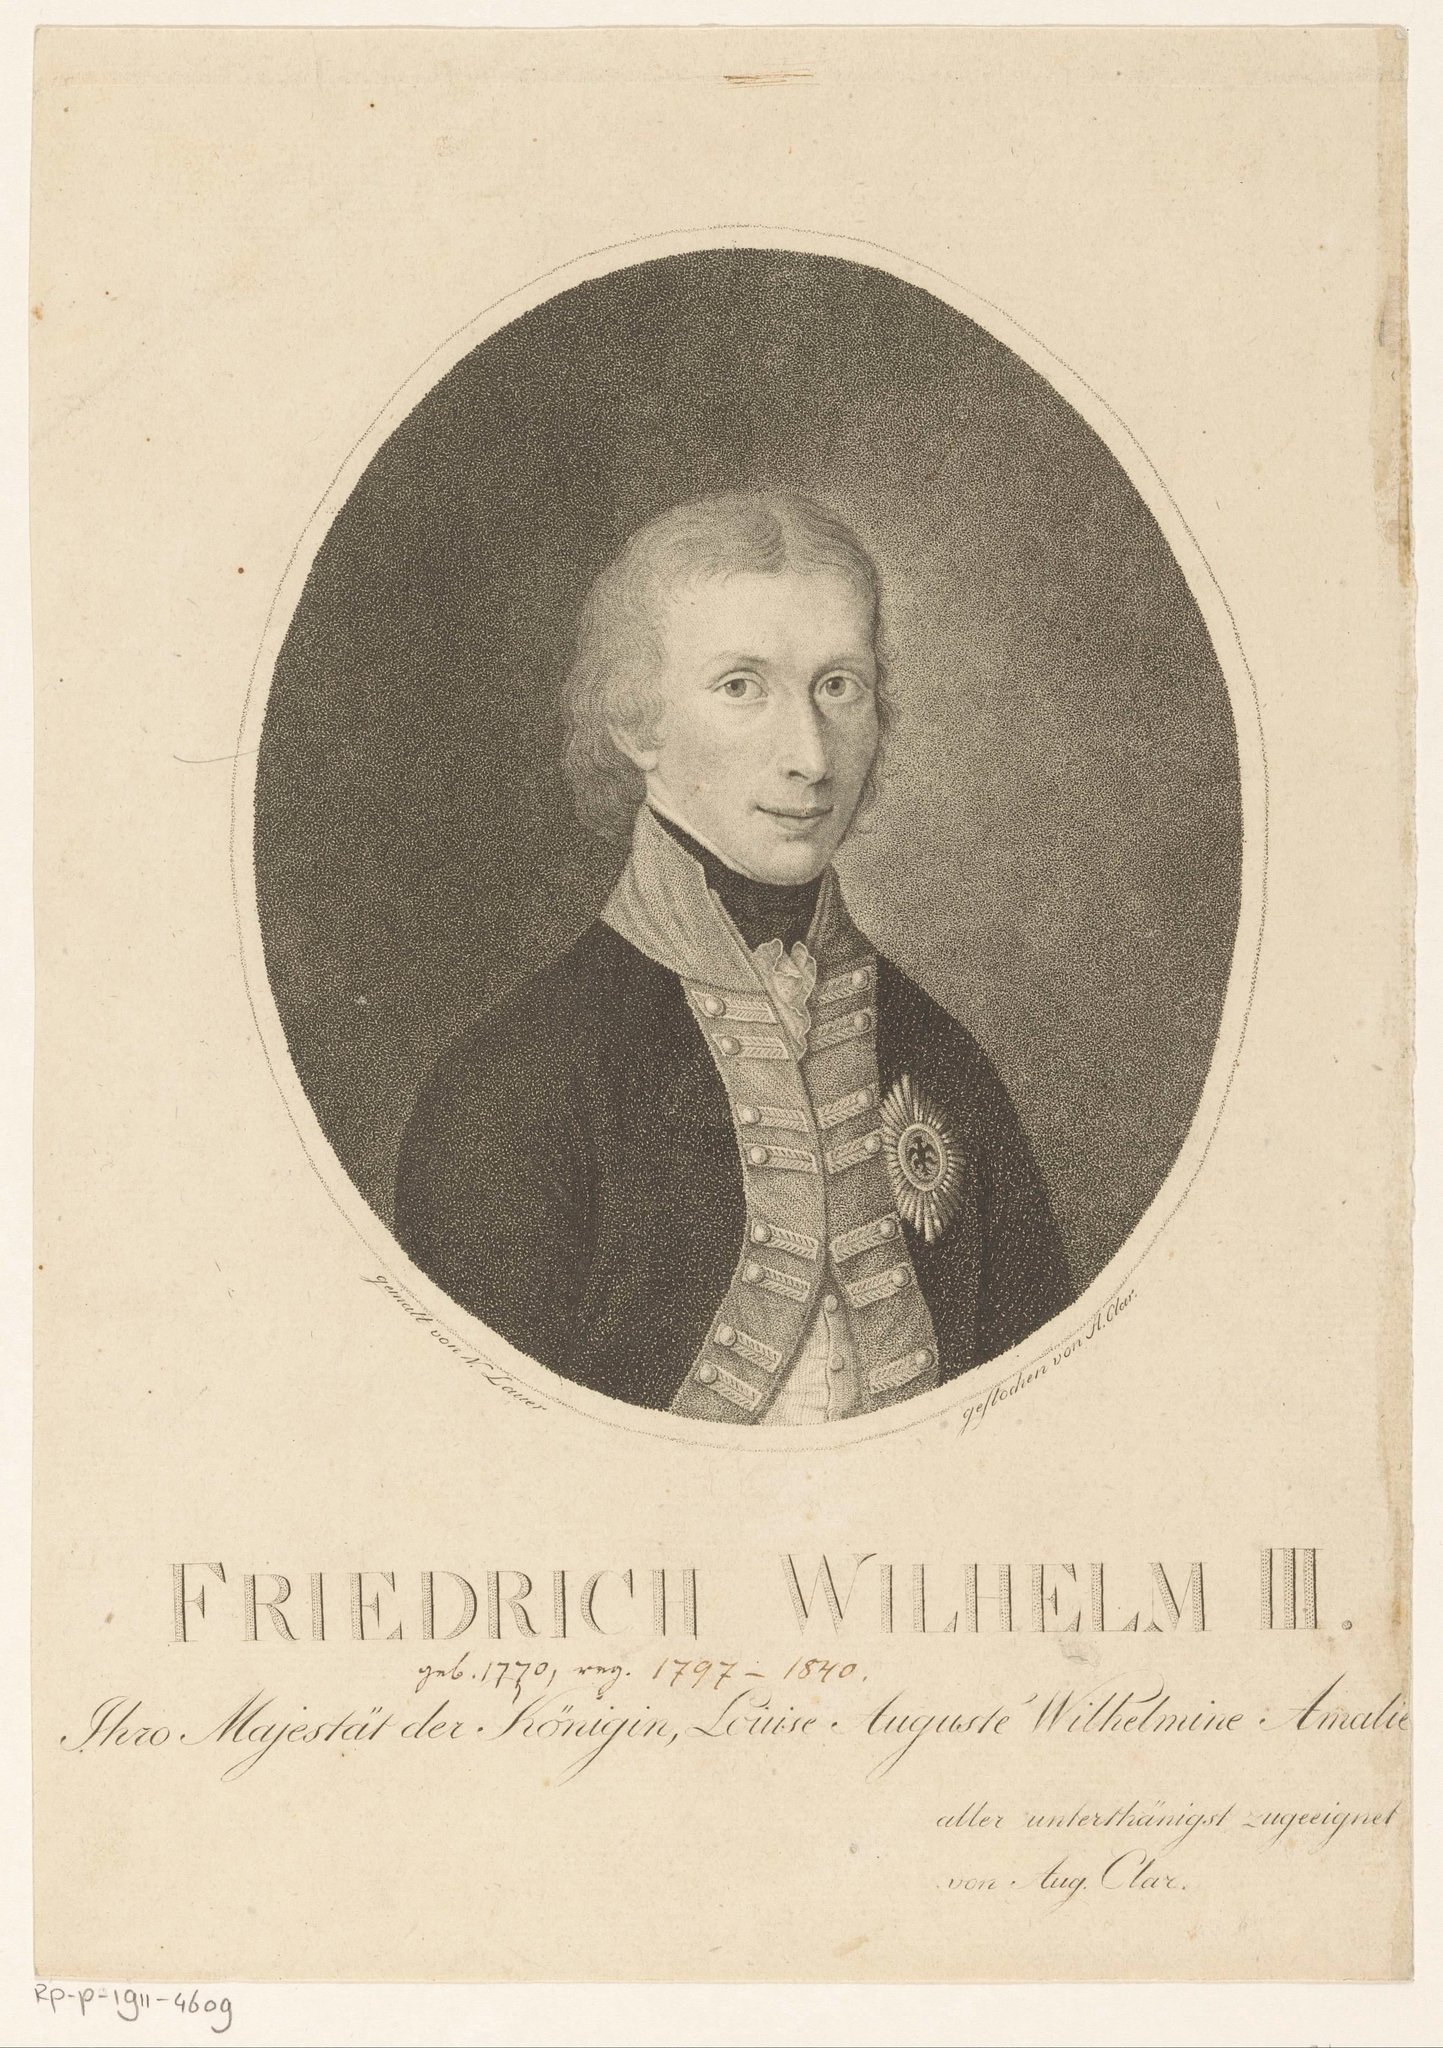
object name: print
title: Portret van Friedrich Wilhelm III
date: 1780-1844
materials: paper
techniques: stippling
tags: berlin, frederik willem iii koning van pruisen, knighthood order (with name) - insignia of a knighthood order, e.g.: badge, chain (with name of order), historical persons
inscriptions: collector's mark: Lugt 2228